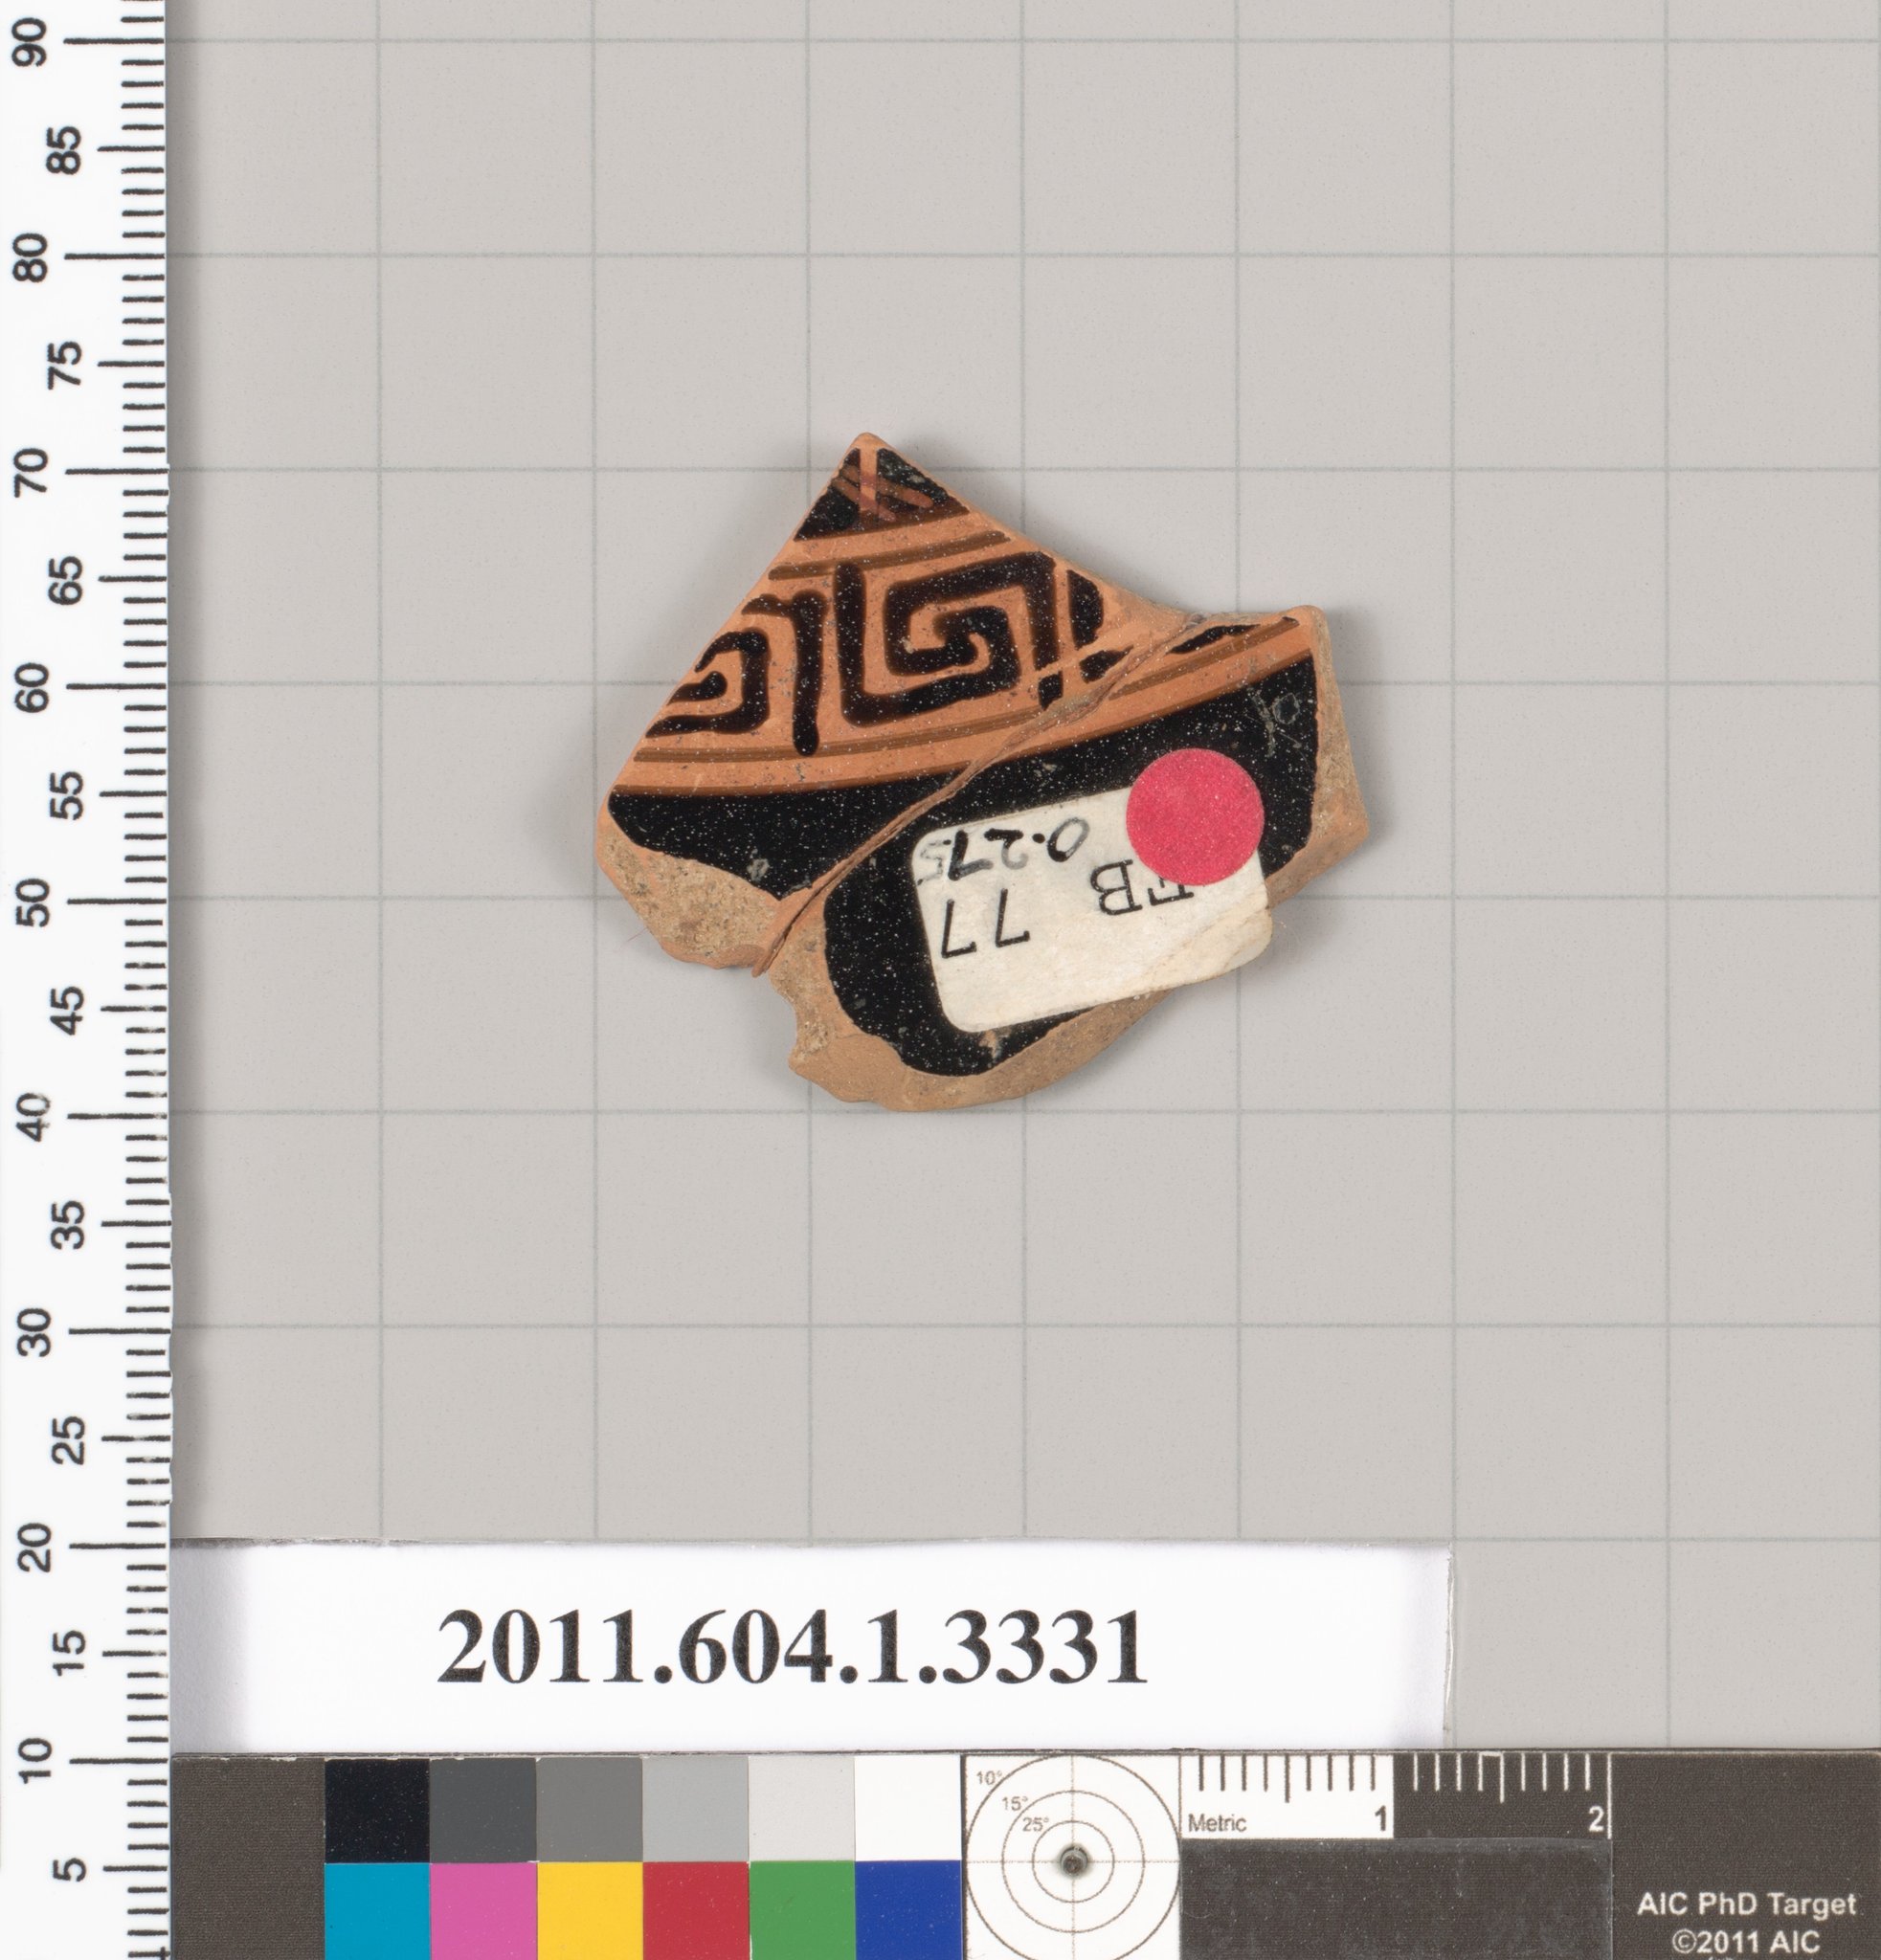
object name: kylix fragment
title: Terracotta fragment of a kylix (drinking cup)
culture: greek, attic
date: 500-480 BCE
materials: terracotta